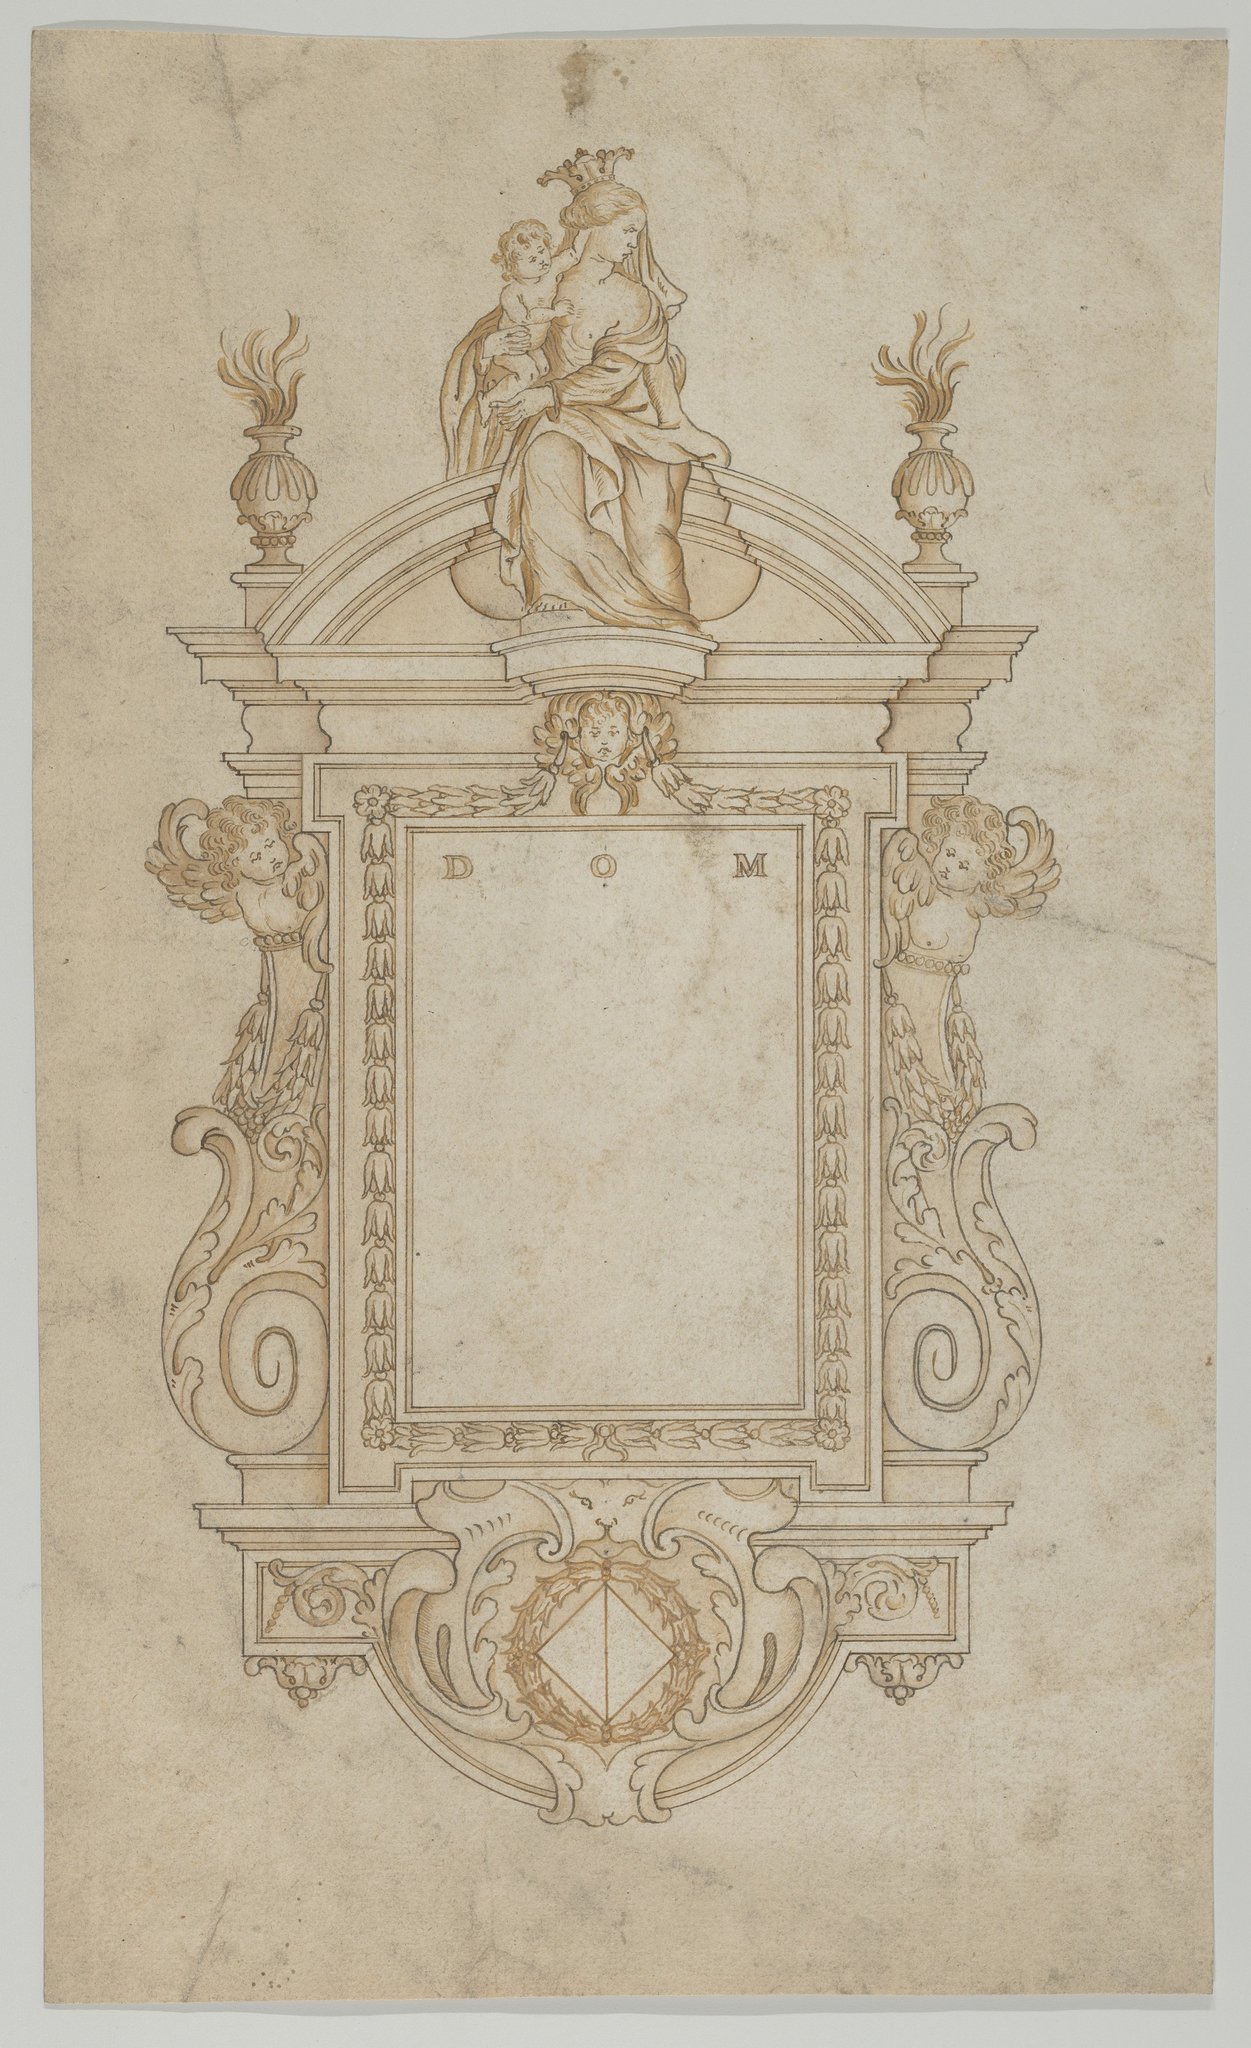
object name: drawing ornament architecture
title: Design for an Epitaph surmounted by a Statue of the Virgin and Child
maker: anonymous, flemish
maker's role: artist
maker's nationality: flemish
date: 1601-1700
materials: ink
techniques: pen, wash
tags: madonna and child